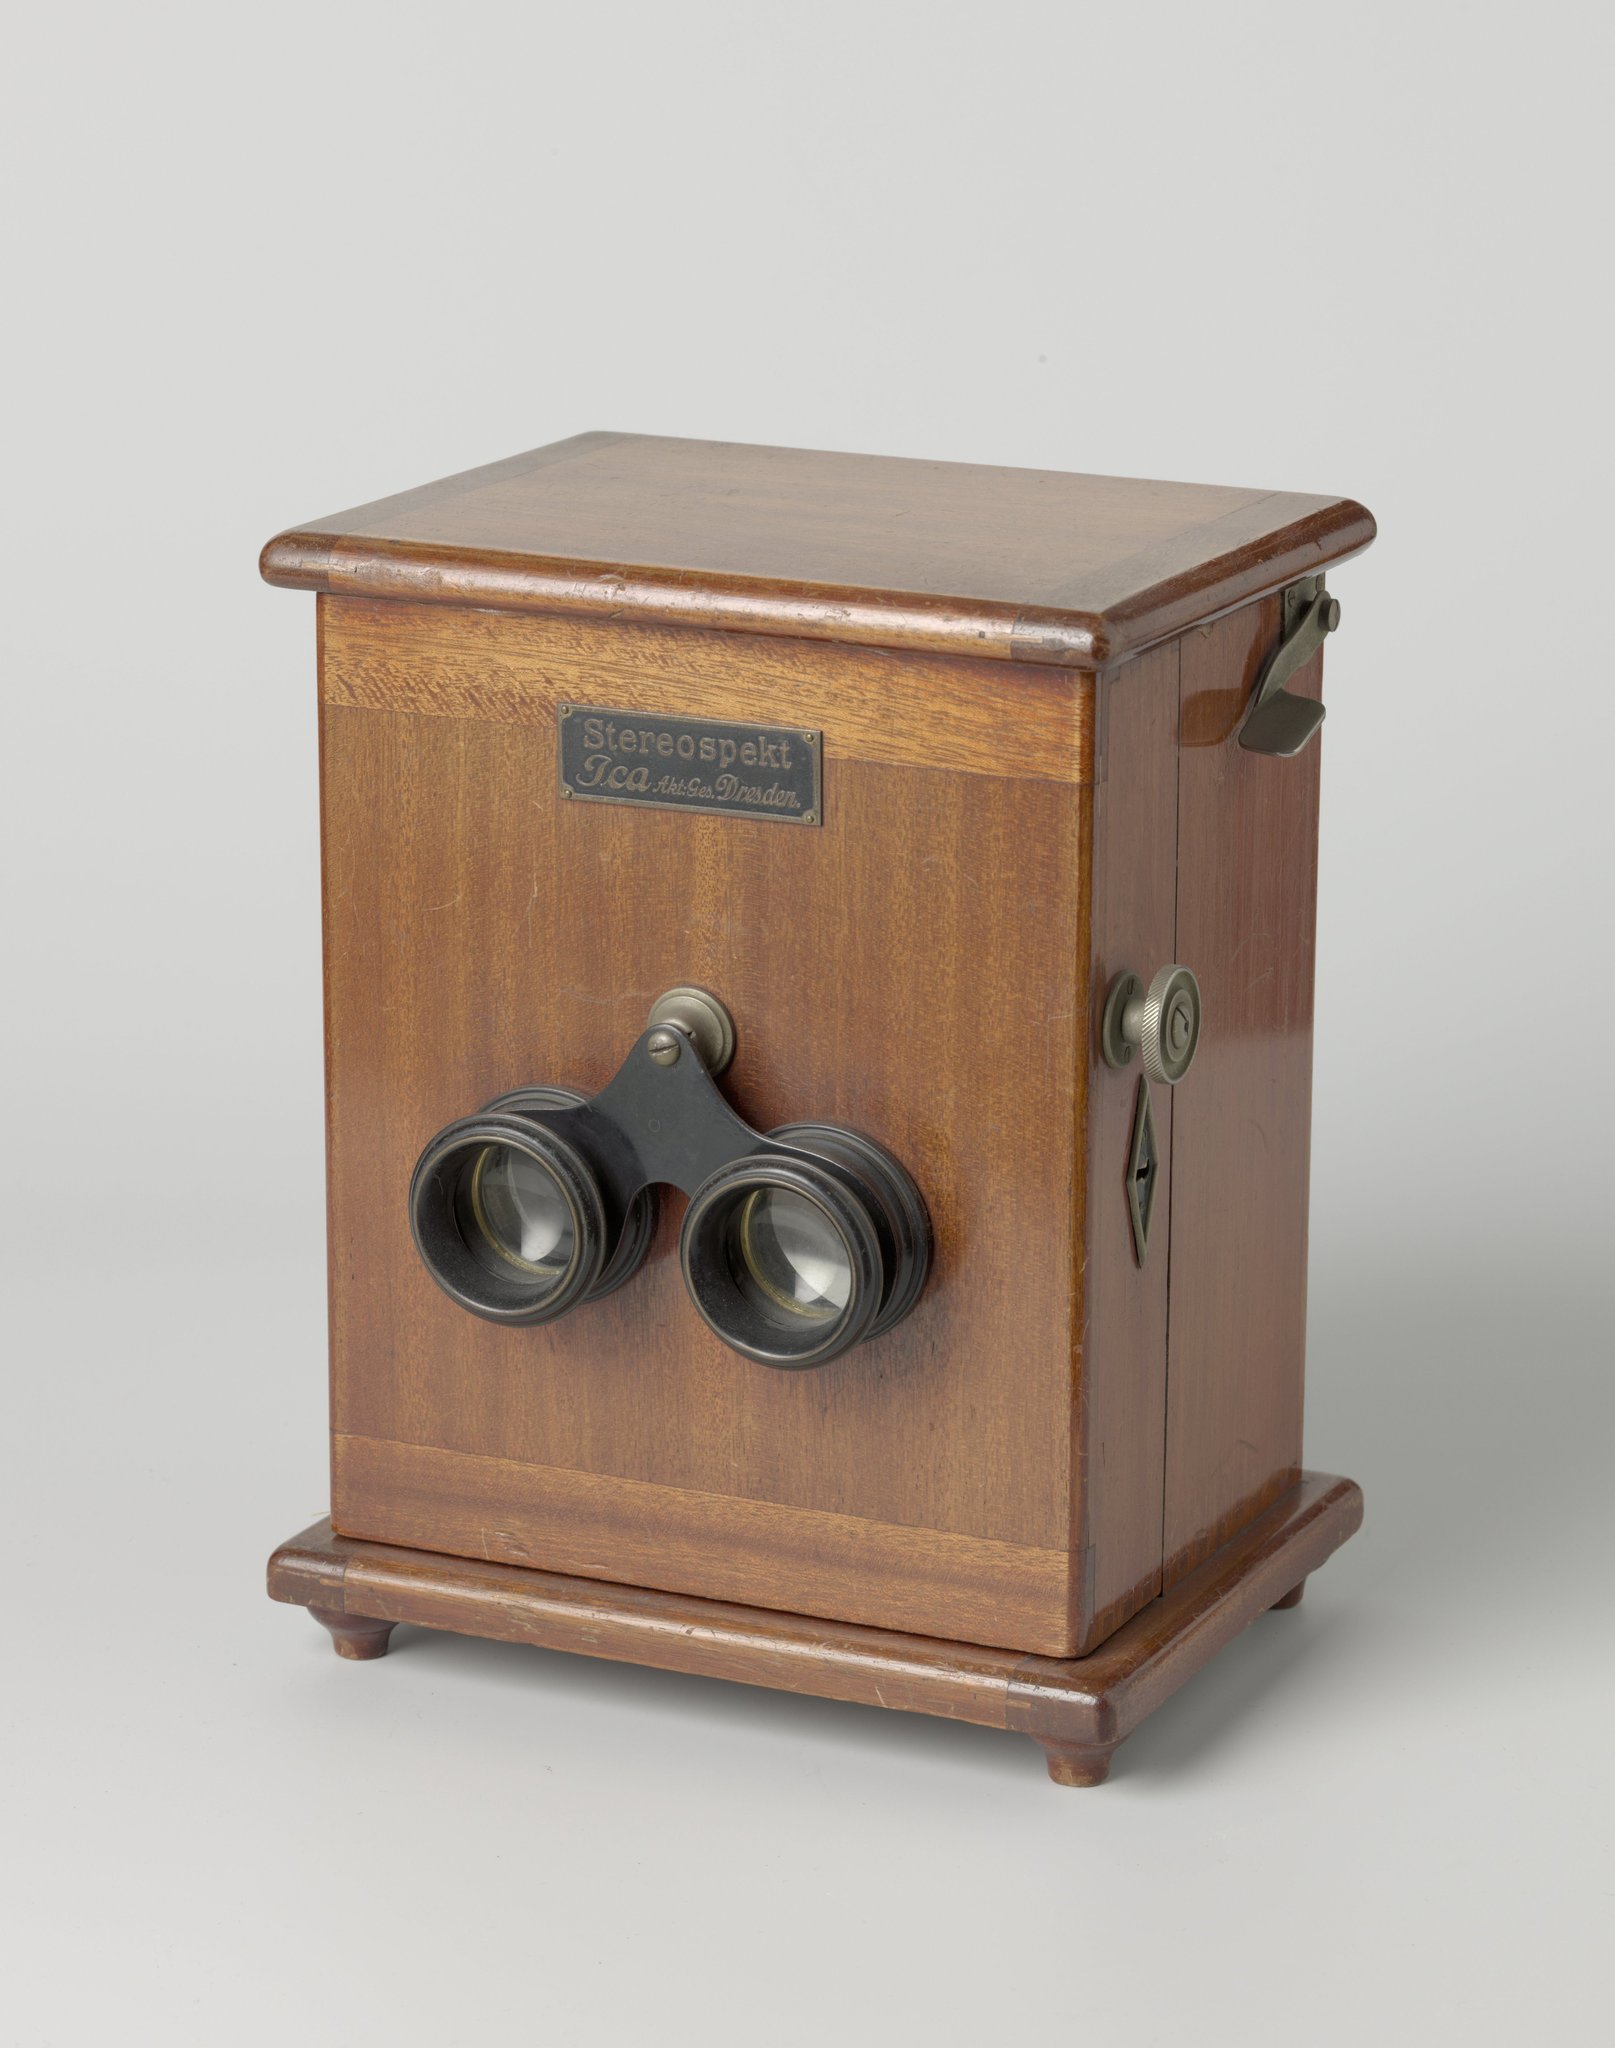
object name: stereoscope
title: Stereoscoop, type Stereospect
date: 1920-1925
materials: glass, metal, wood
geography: dresden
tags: dresden